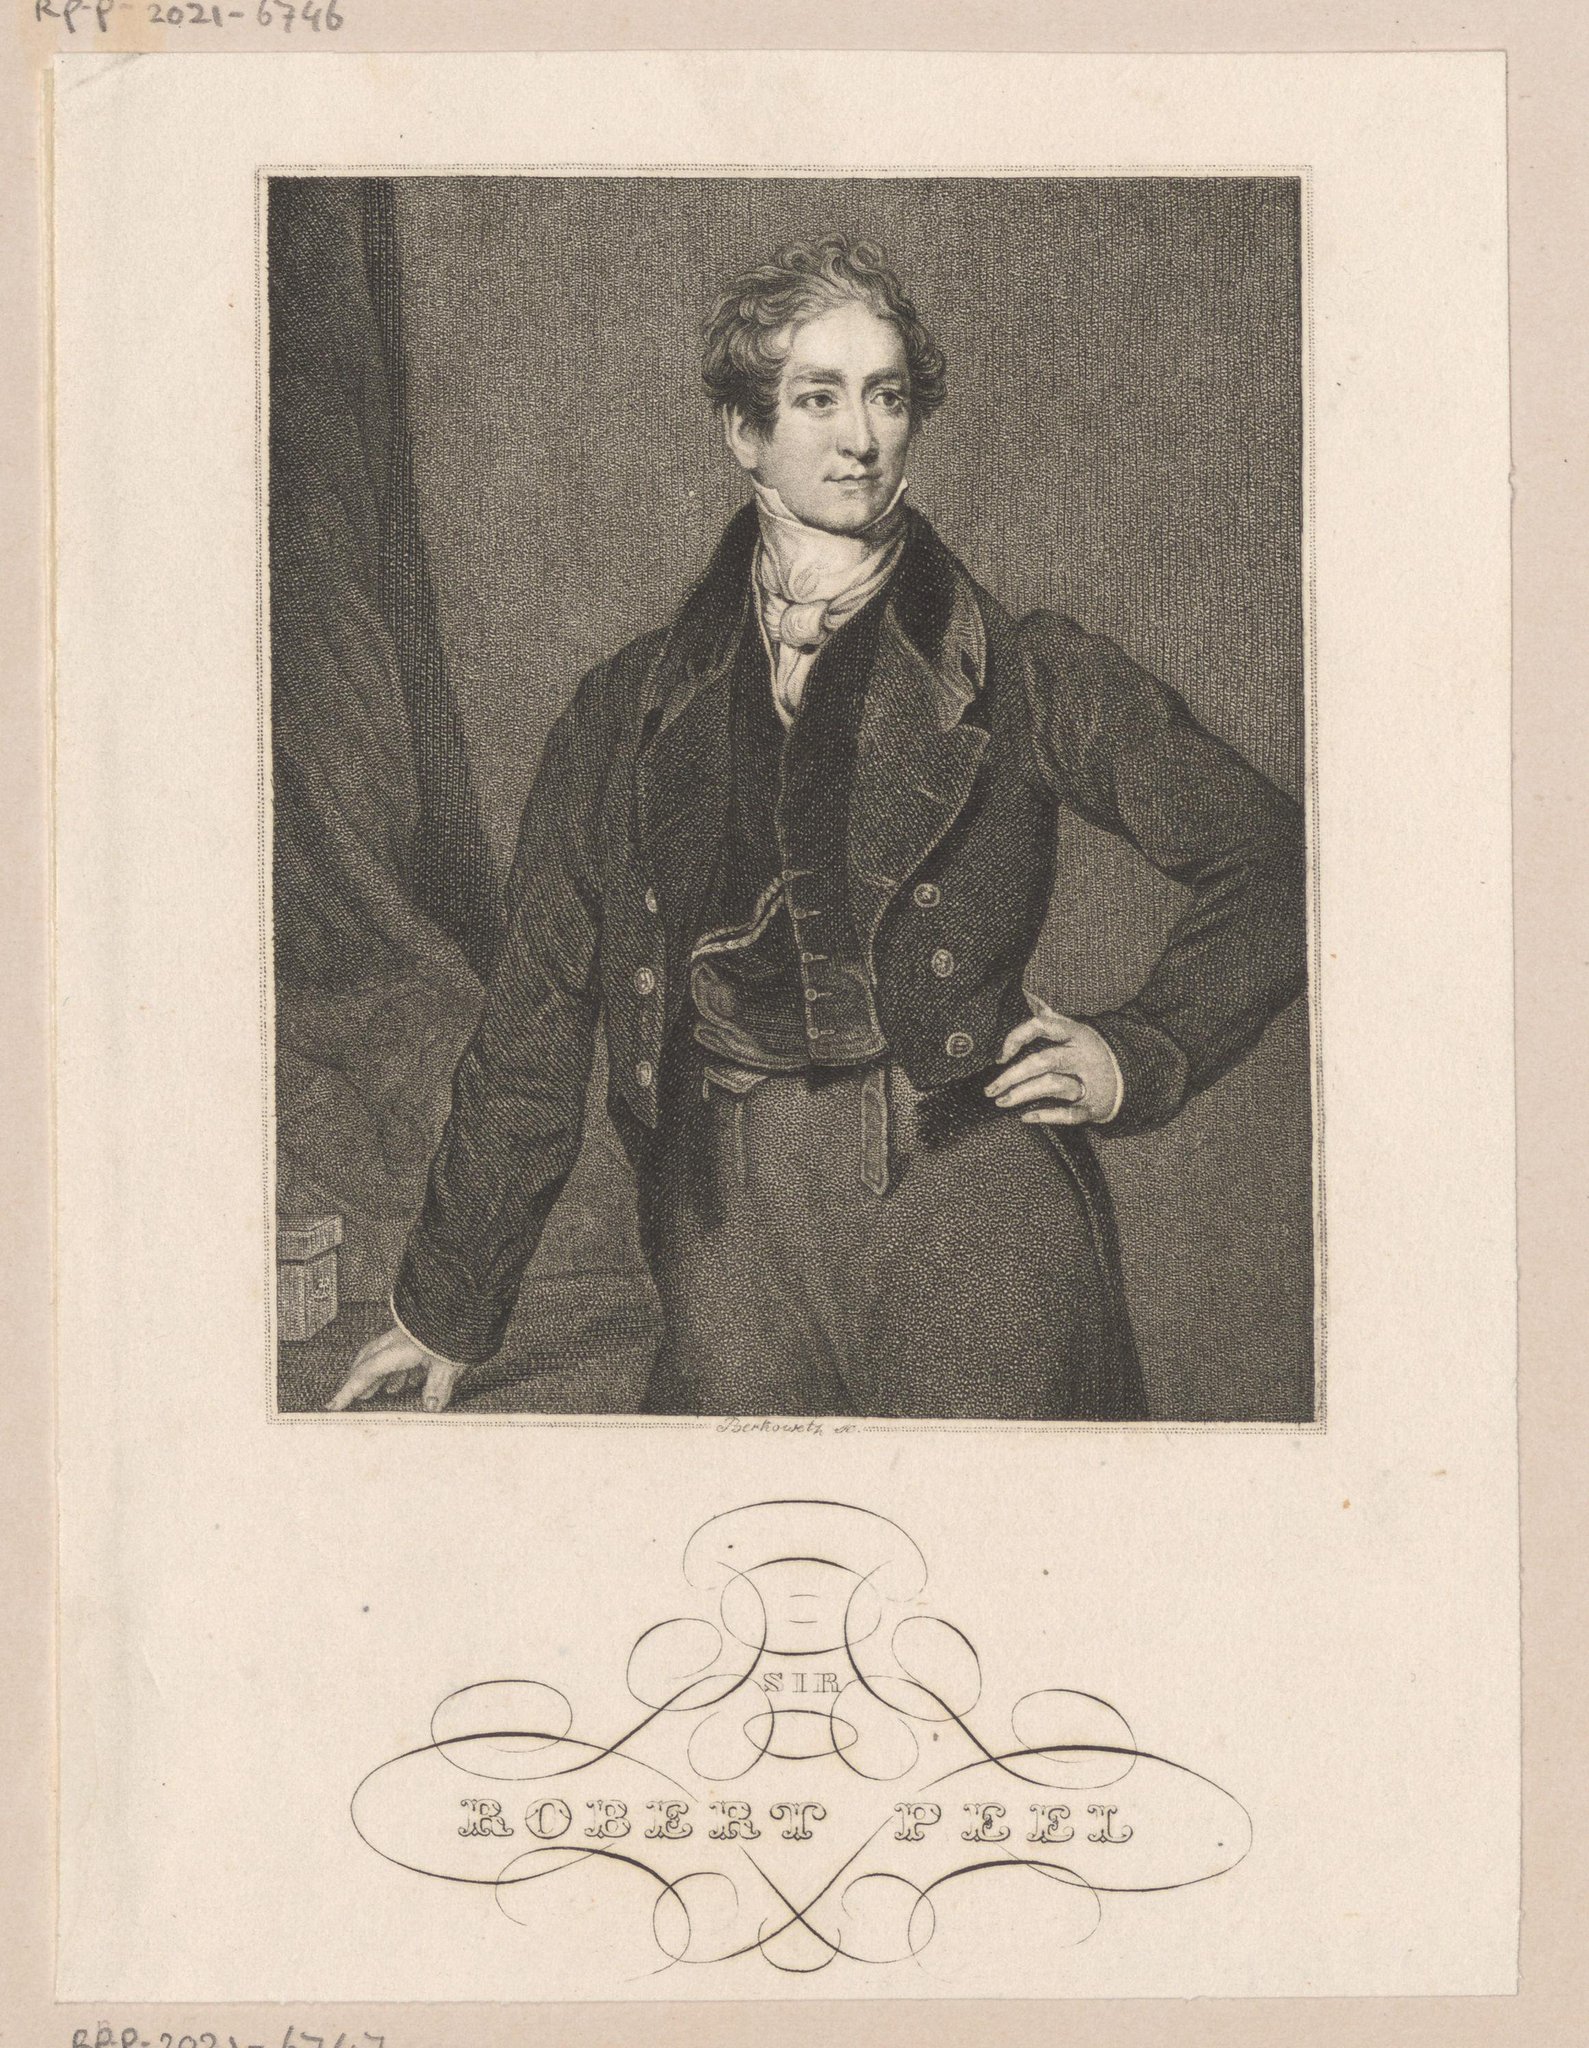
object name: print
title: Portret van Robert Peel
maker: joseph berkowetz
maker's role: print maker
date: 1817-1835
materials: paper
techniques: engraving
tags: london, adult man, historical persons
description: Prent behoort waarschijnlijk tot de serie 'Zeitgenossen'.